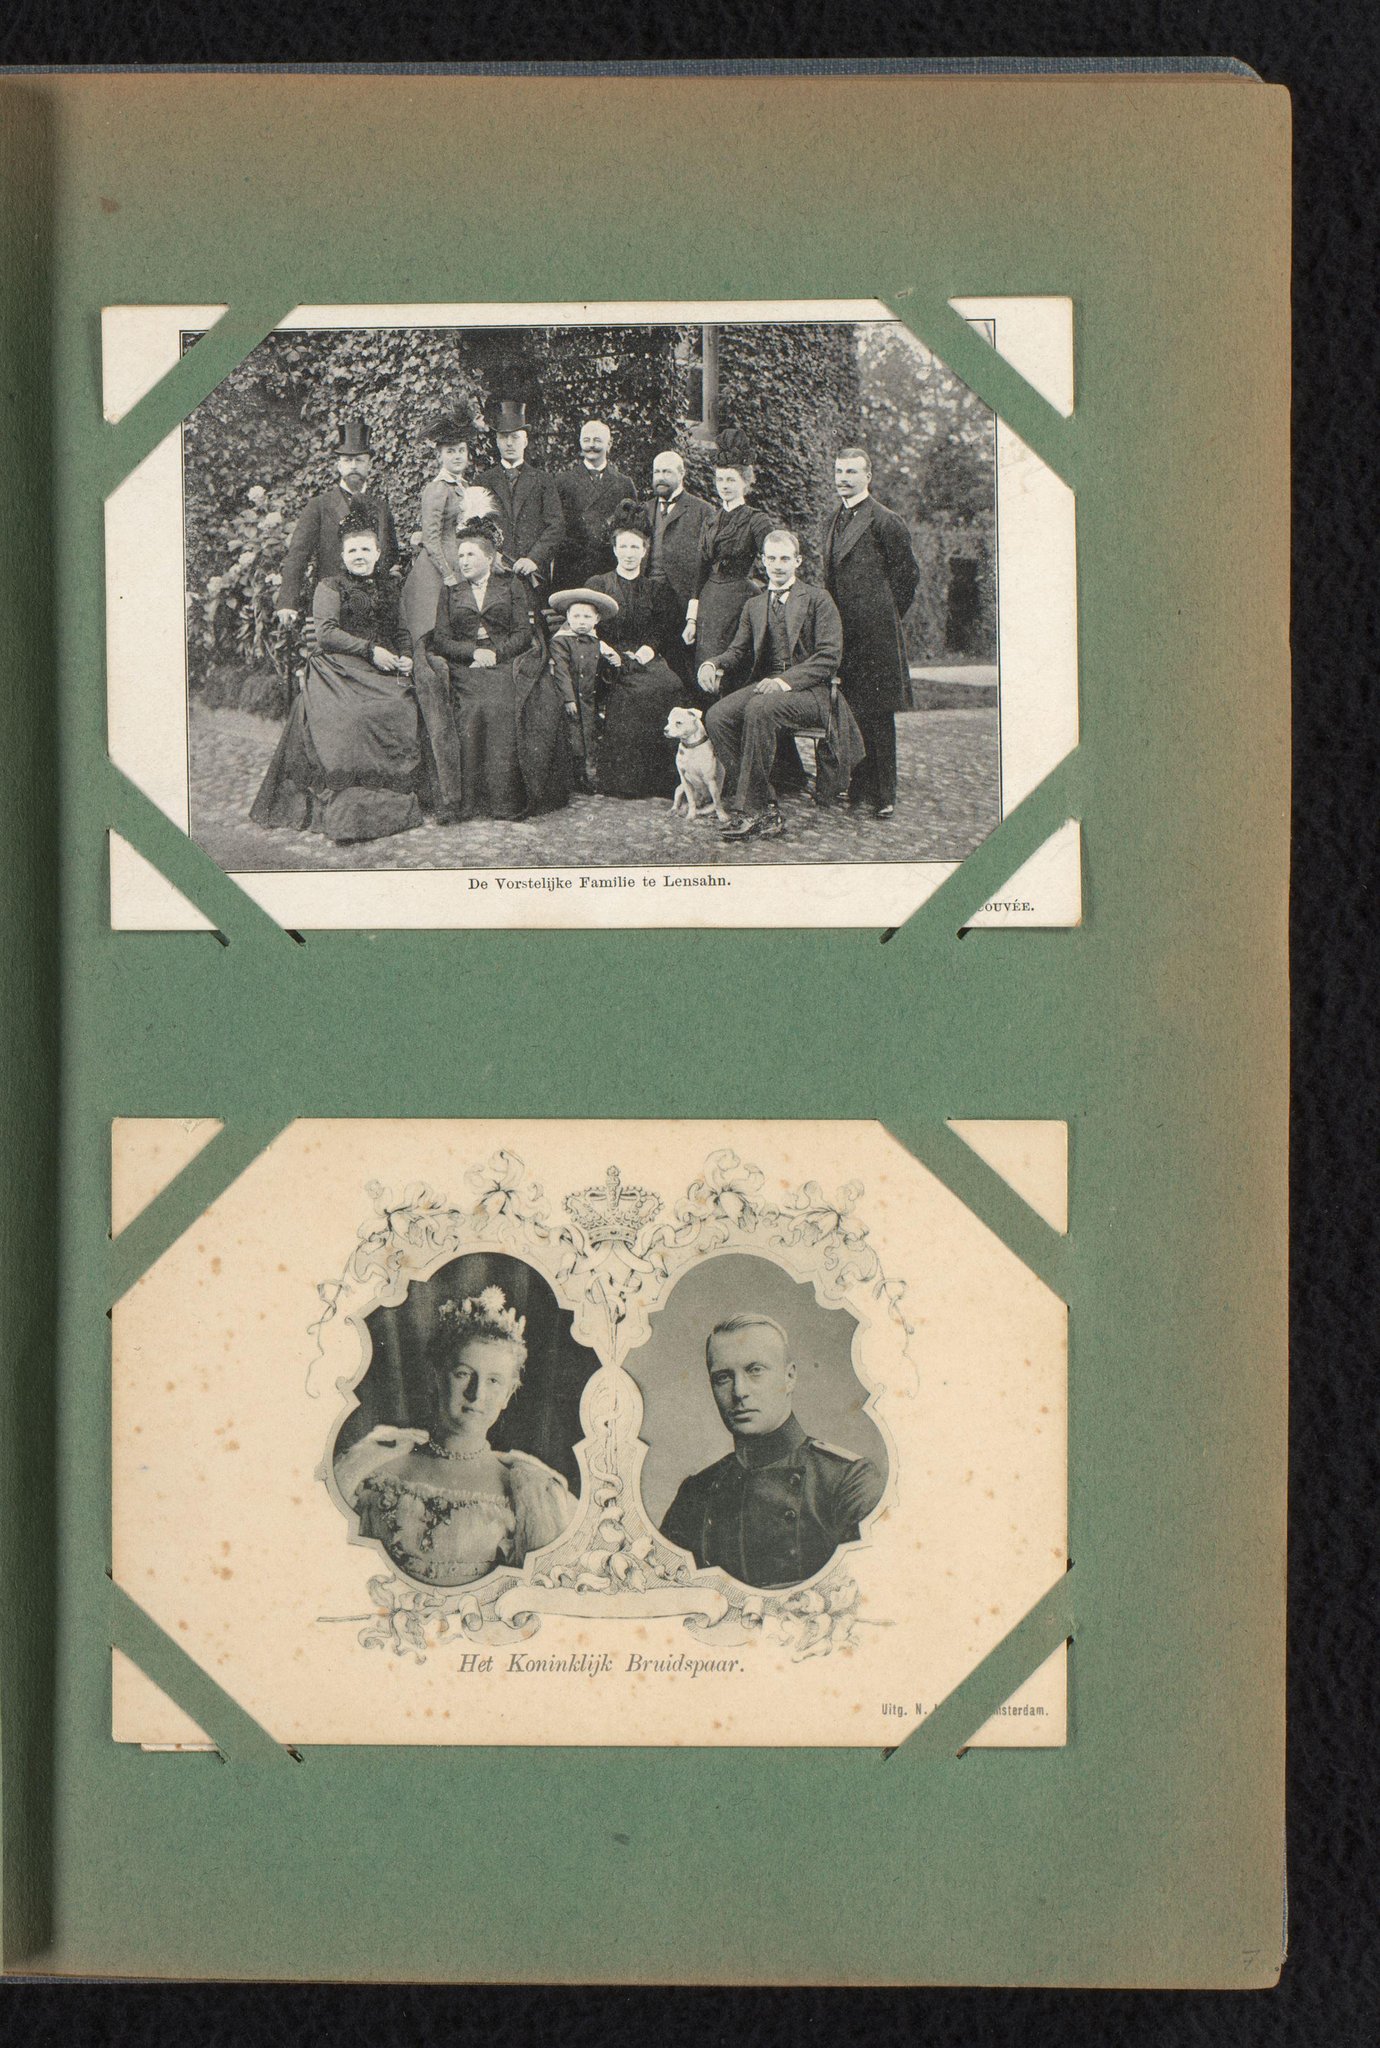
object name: ansichtkaart, prentbriefkaart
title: Twee prentbriefkaarten met een groepsportret van de koninklijke familie en een dubbelportret van koningin Wilhelmina en prins Hendrik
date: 1900-1901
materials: cardboard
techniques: photograph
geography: lensahn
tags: print maker, wilhelmina of the netherlands, the hague, hendrik (prins der nederlanden (1876-1934)), historical persons - bb - woman, family group, especially parents with their child(ren), historical persons, queen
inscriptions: inscription: ‘Het Koninklijke Bruidspaar.’, inscription: ‘De Vorstelijke Familie te Lensahn.’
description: Het groepsportret werd genomen te Lensahn in Hofstein op 4 november 1900. Van links naar rechts staand: Hertog-regent Johann Albrecht, Koningin Wilhelmina der Nederlanden, Hertog Hendrik van Mecklenburg, Groothertog Frederik August van Oldenburg, Hertog Paul Frederik van Mecklenburg, Hertogin Sophie Charlotte van Oldenburg, Hertog Adolf Frederik van Mecklenburg. Zittend: Koningin Emma, Groothertogin Marie van Mecklenburg, Erf-Groothertog Nicolaas van Oldenburg, Groothertogin Elisabeth van Oldenburg en Groothertog Frederik Frans IV van Mecklenburg. Deze prenten maken deel uit van een album.